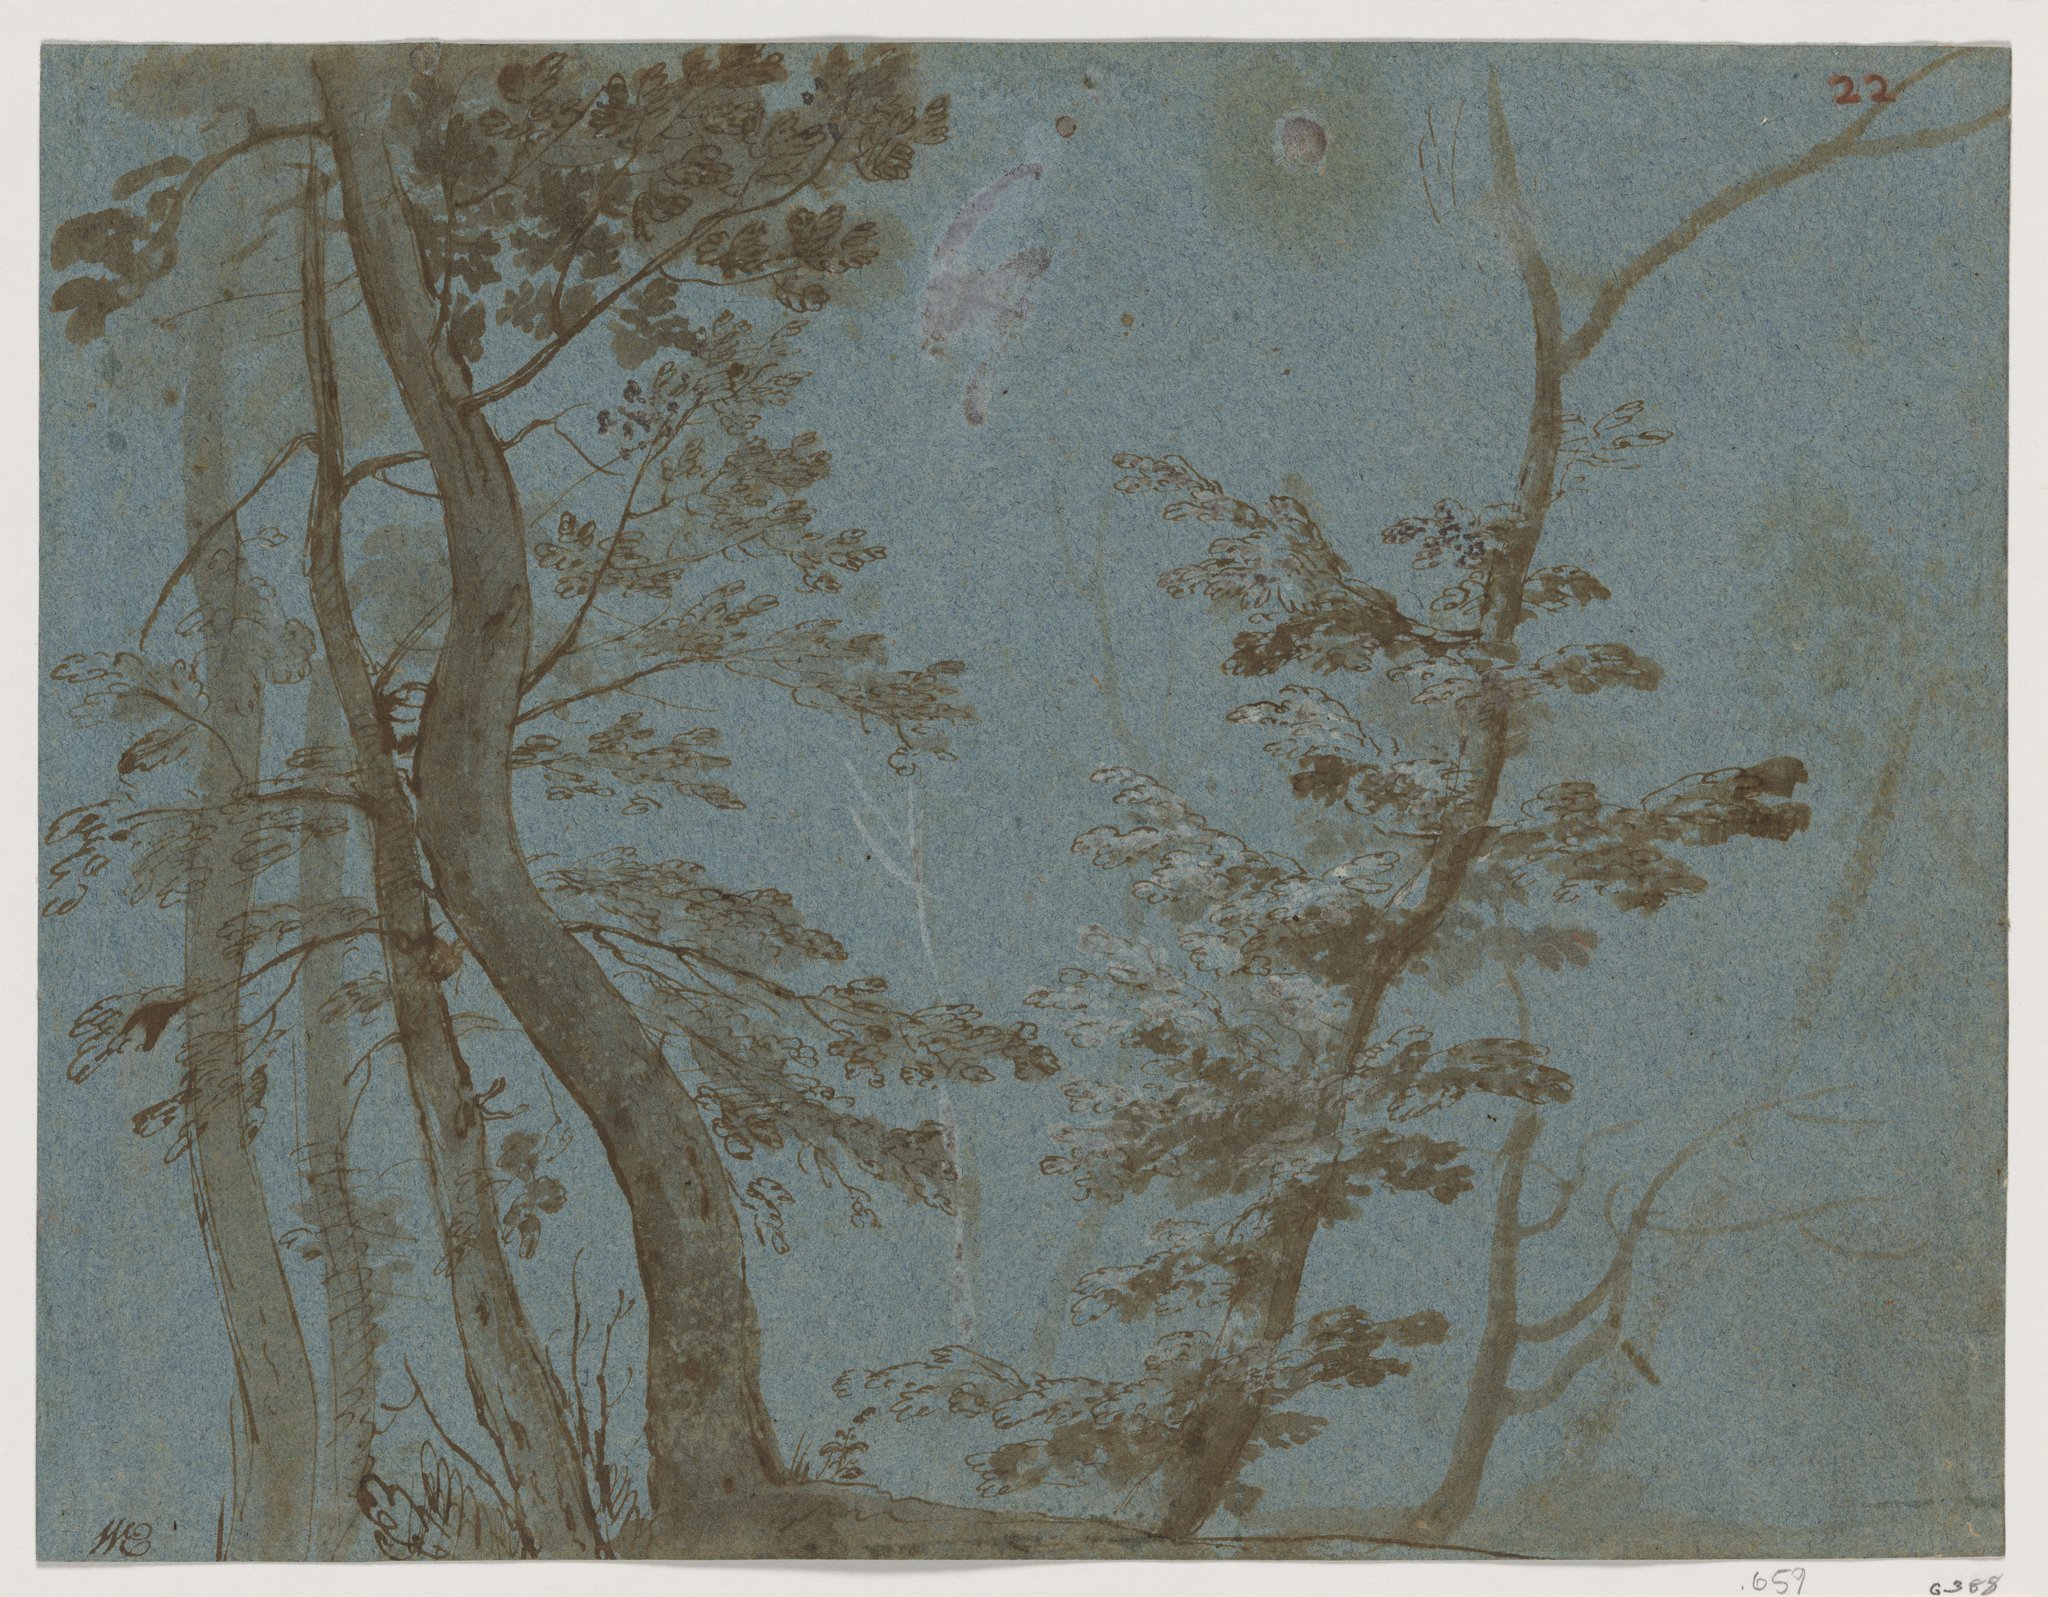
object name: drawing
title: Trees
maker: giovanni francesco grimaldi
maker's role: artist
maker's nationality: italian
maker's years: 1606-1680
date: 1650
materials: gouache, ink, paper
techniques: heightening, pen, wash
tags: trees